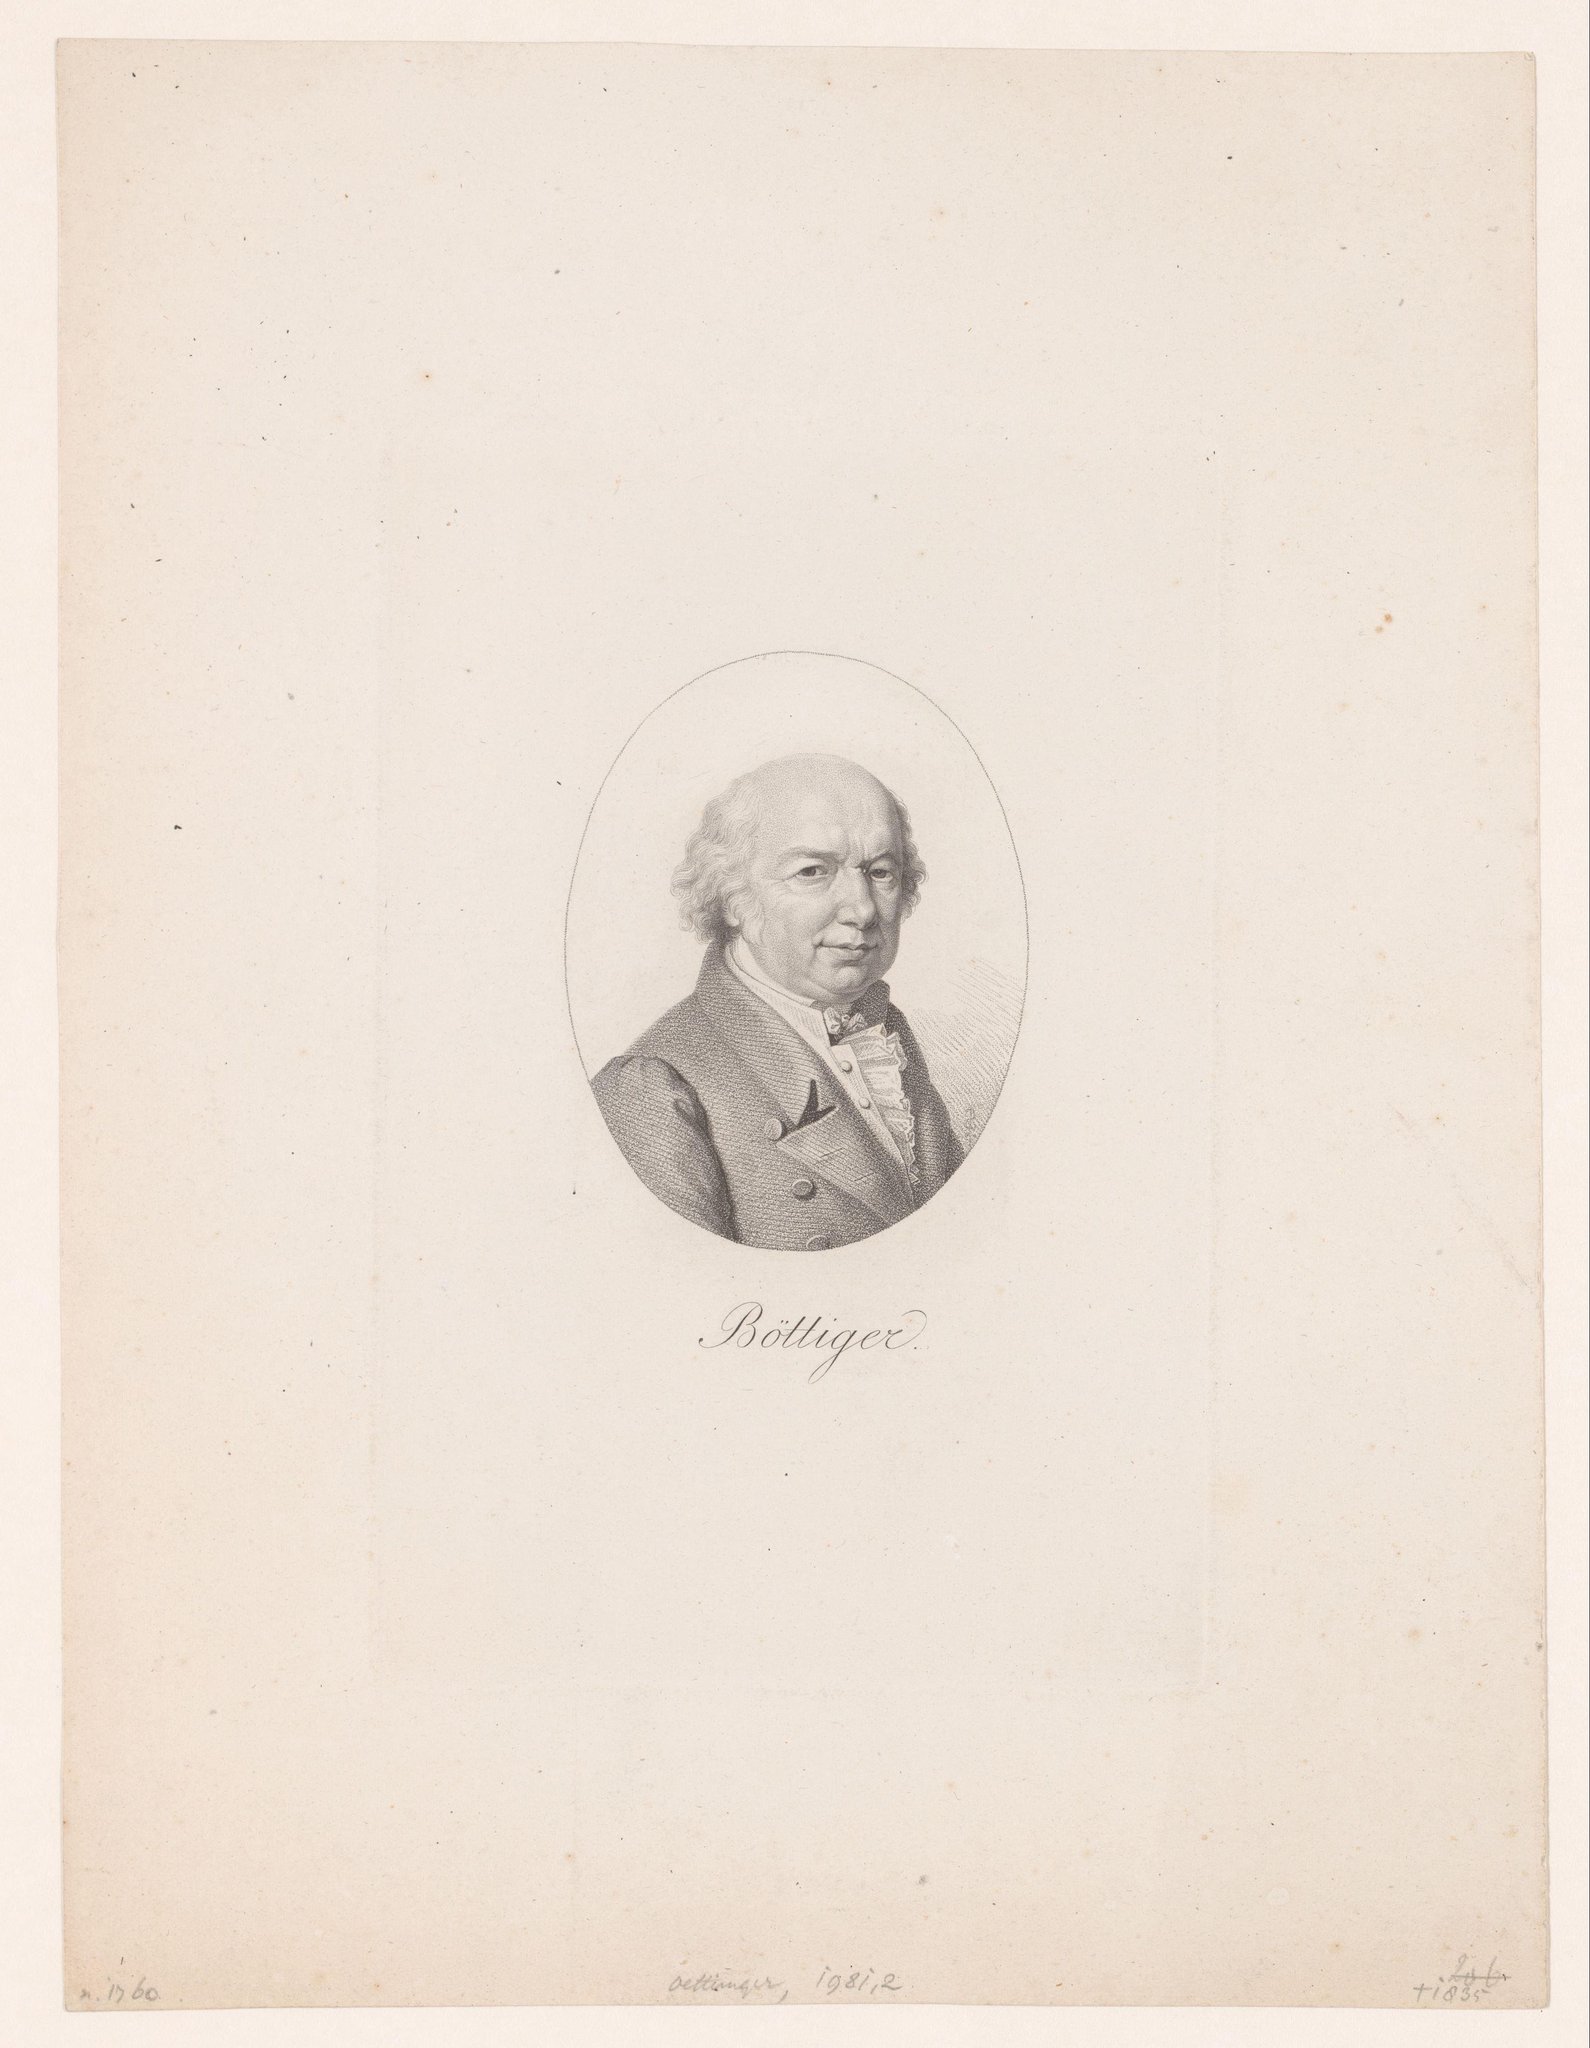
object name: print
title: Portret van Karl August Böttiger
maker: carl august schwerdgeburth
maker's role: print maker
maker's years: 1785-1878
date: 1795-1878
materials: paper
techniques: printmaking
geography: weimar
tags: historical persons